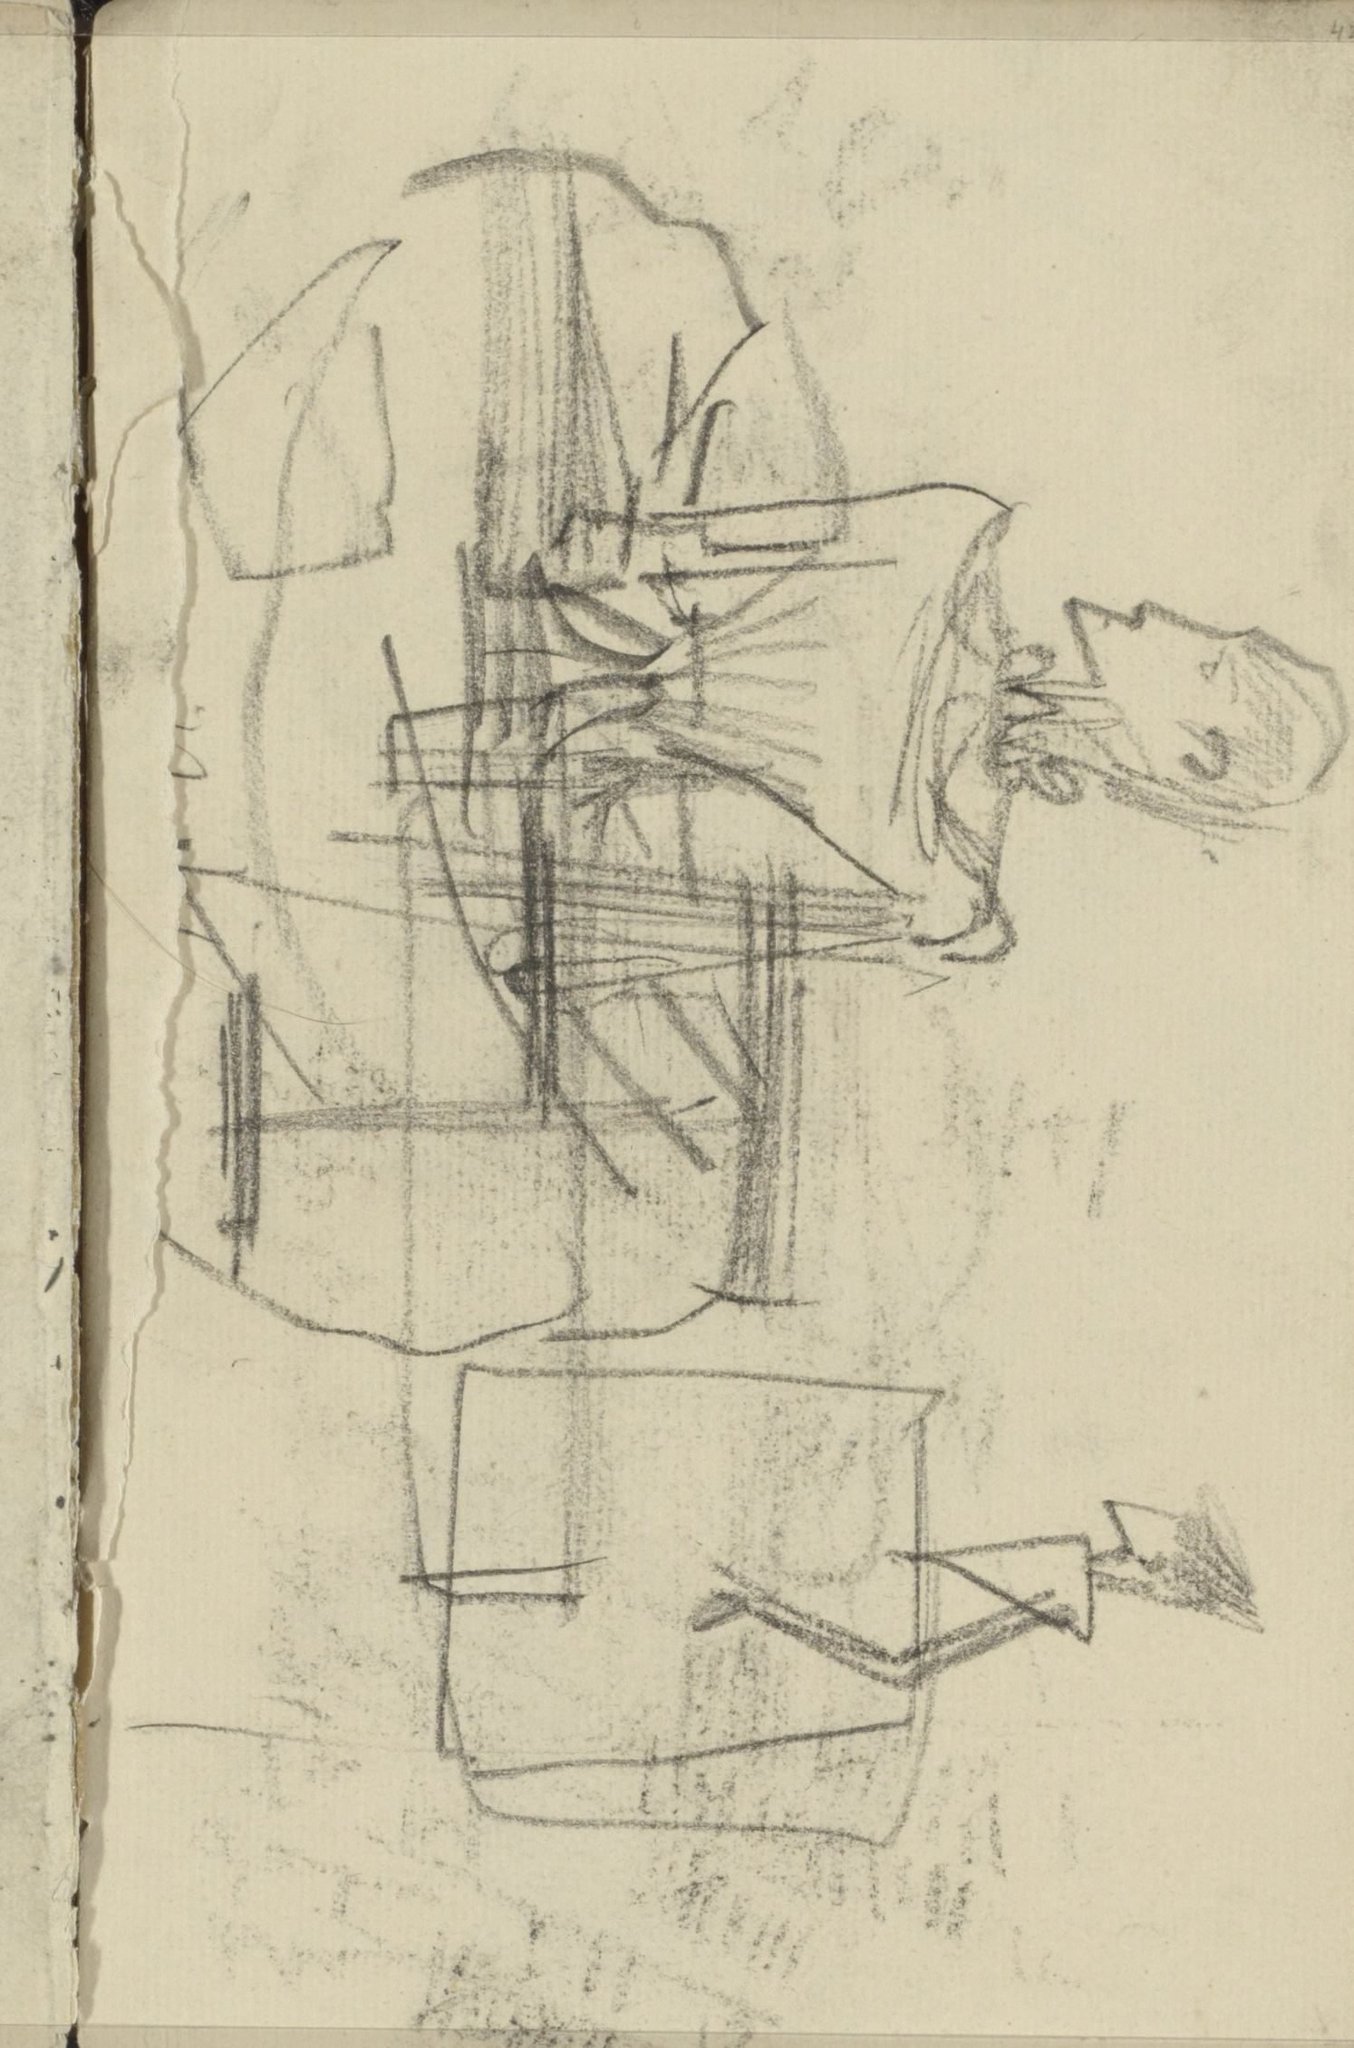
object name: sketchbook leaf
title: Figuurstudies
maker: george hendrik breitner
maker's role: draughtsman, painter, print maker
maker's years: 1857-1923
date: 1882-1884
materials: chalk, paper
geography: the hague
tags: carrying something, adult man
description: Pagina 42 uit een schetsboek met 24 bladen.